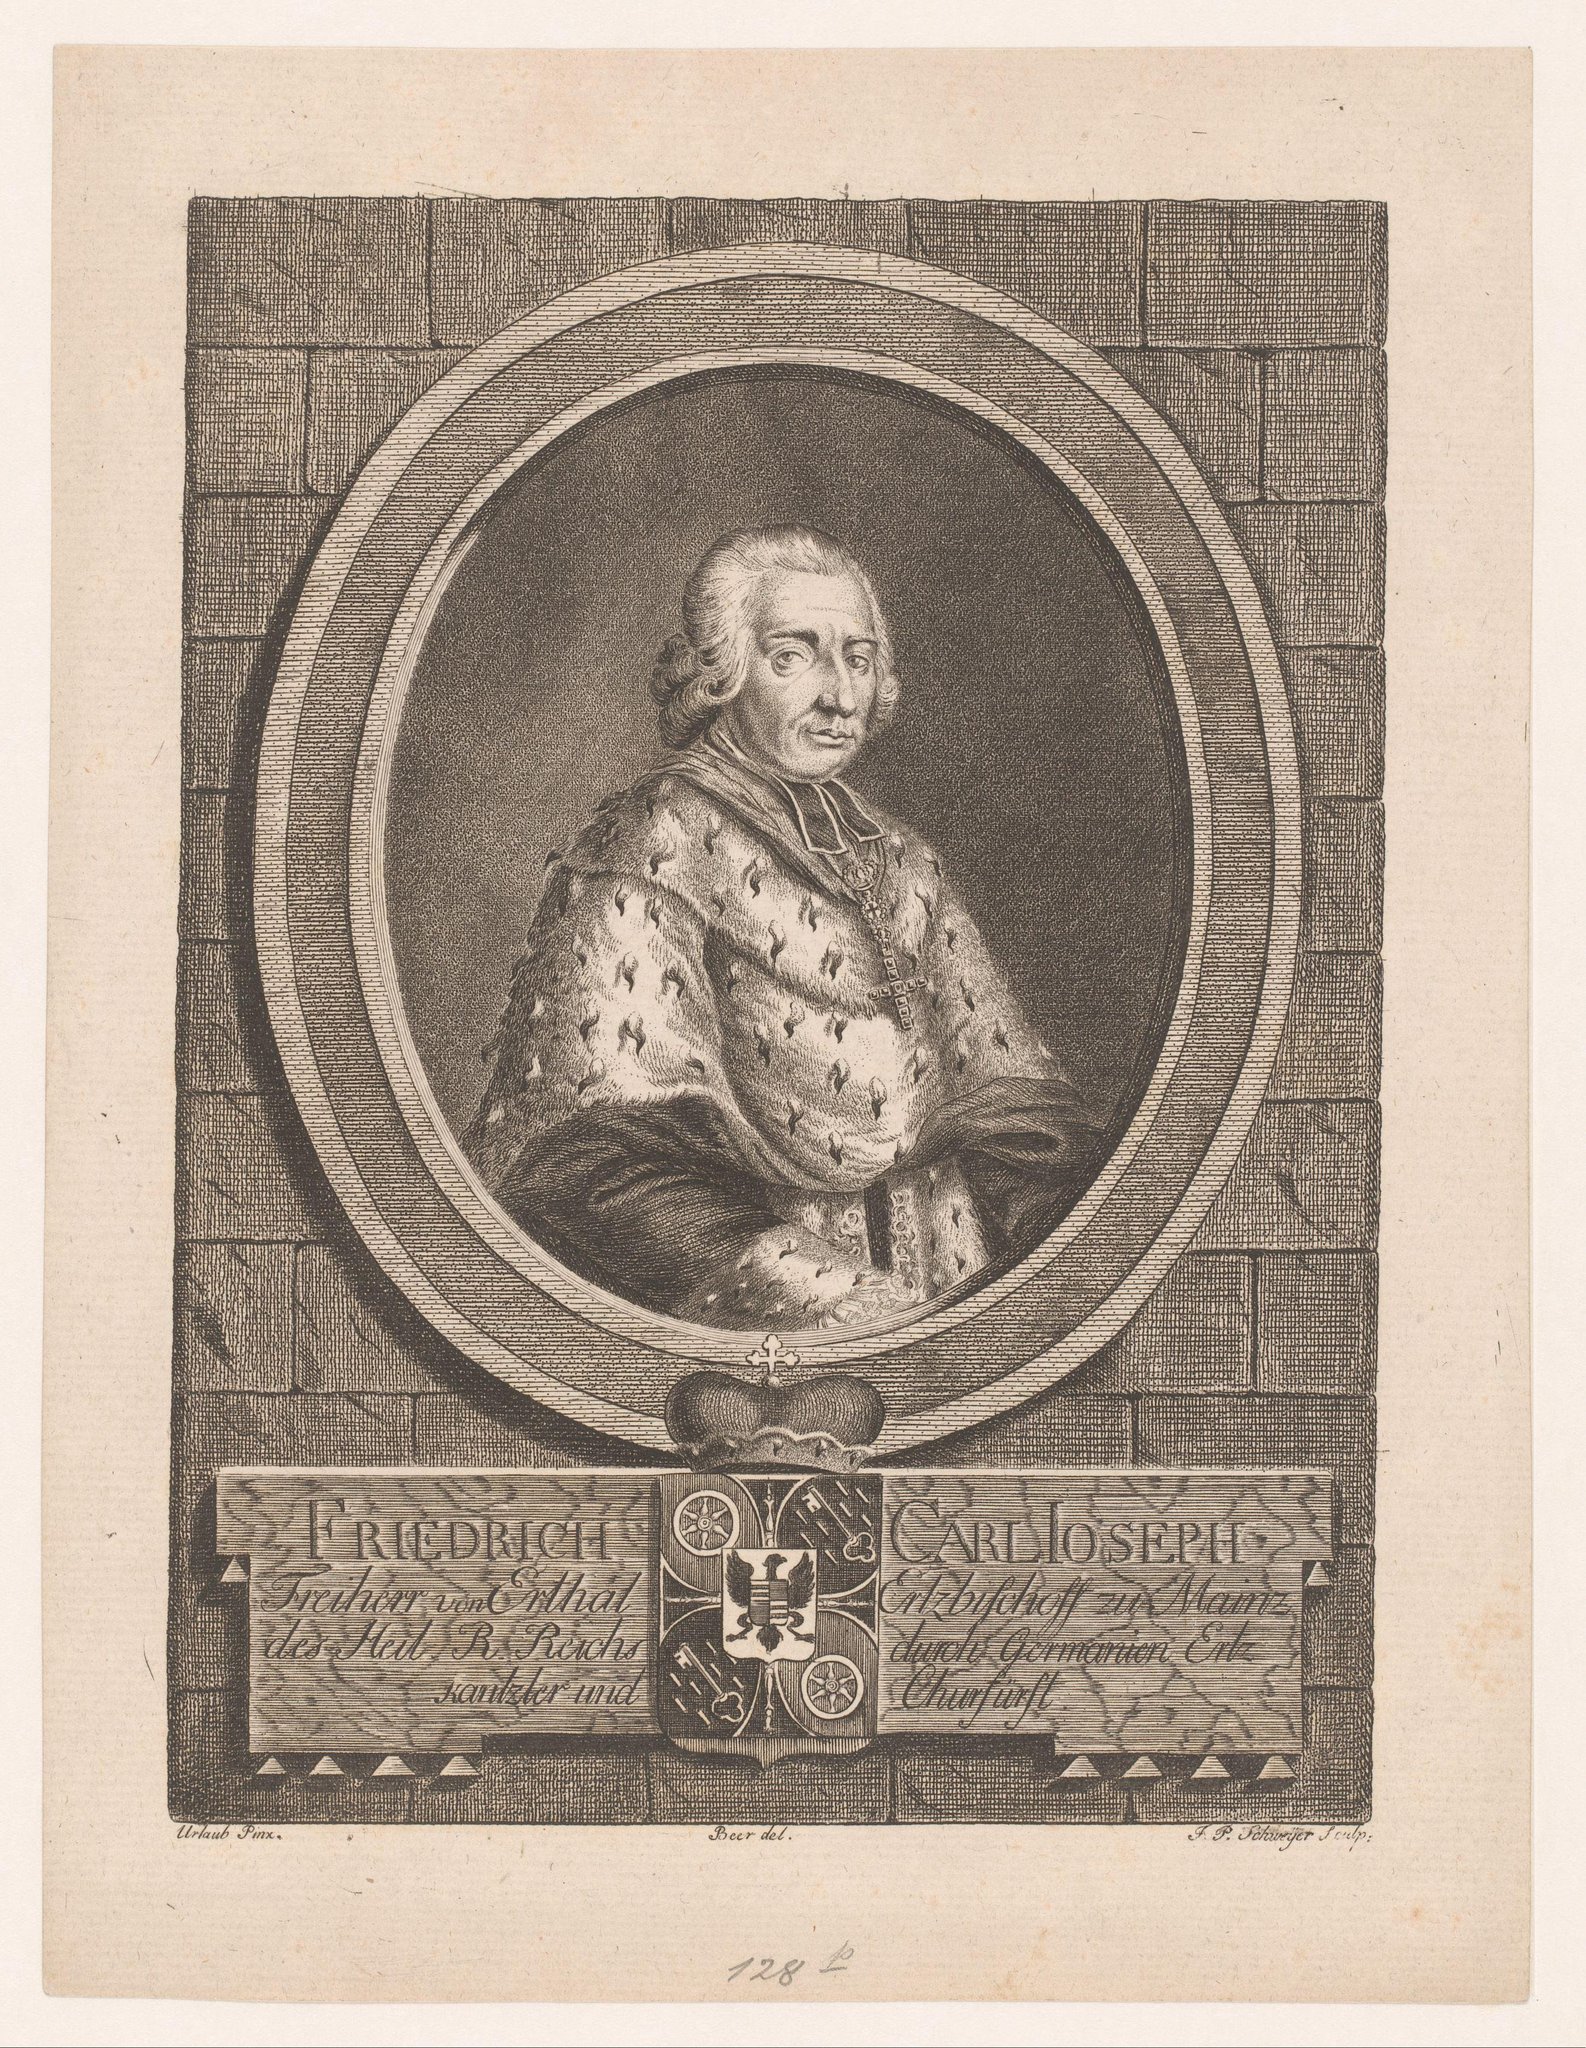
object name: print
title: Portret van Friedrich Karl Joseph, Reichsfreiherr von Erthal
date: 1764-1813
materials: paper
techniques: etching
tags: historical persons, armorial bearing, heraldry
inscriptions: collector's mark: Lugt 2228